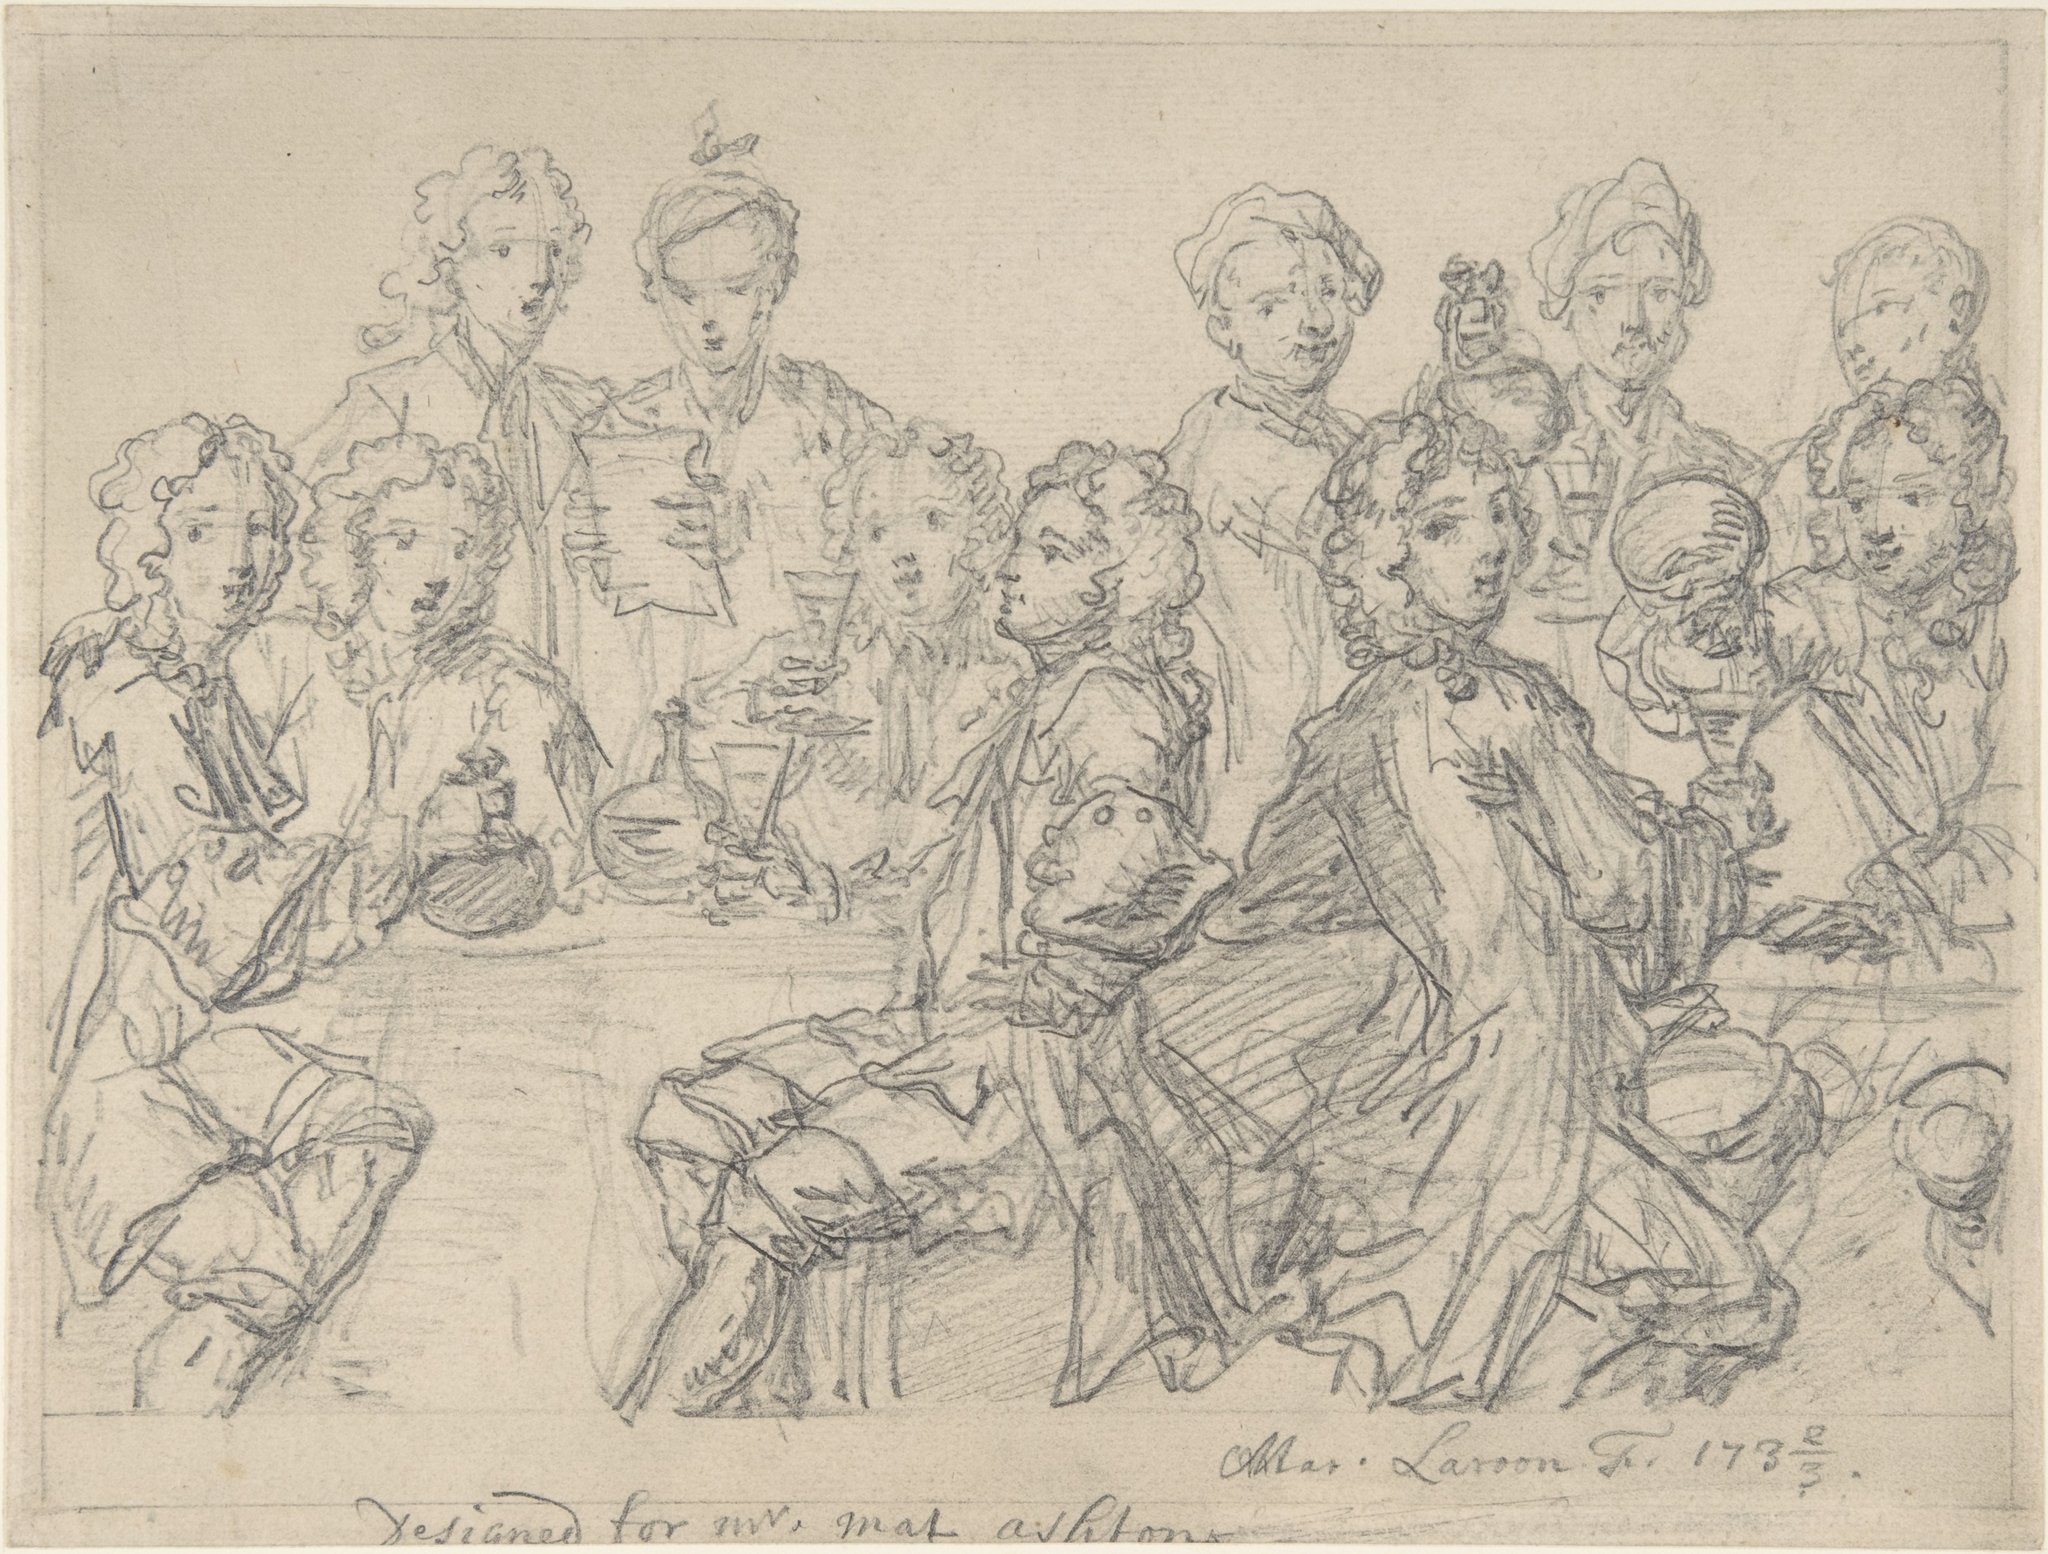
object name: drawing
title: Group of Figures at a Table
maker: marcellus laroon the younger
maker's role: artist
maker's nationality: british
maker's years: 1679-1772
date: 1732-1733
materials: graphite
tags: human figures